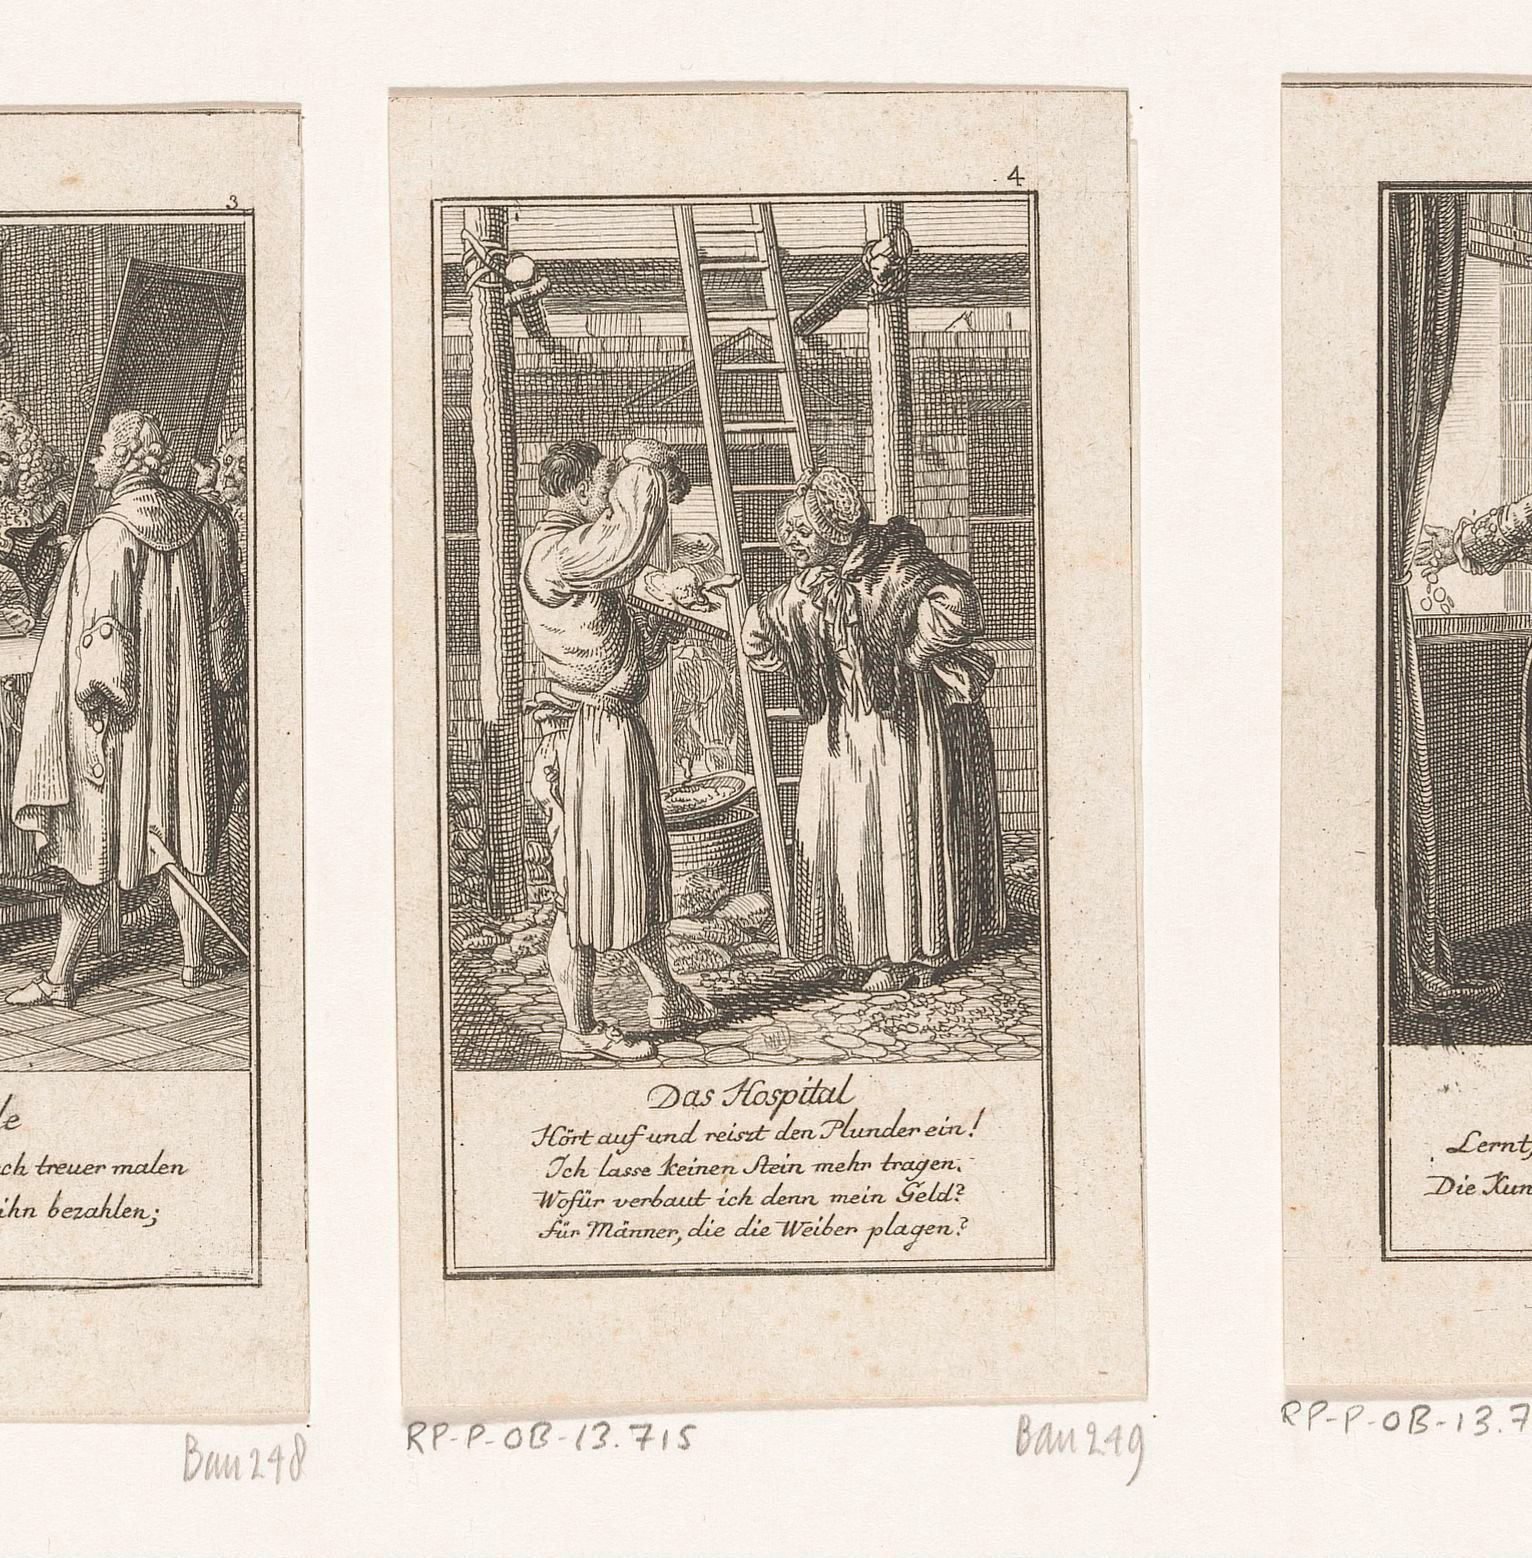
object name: print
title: Elmire en de metselaar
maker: daniel nikolaus chodowiecki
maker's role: draughtsman, print maker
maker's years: 1726-1801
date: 1775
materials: paper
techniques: etching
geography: berlin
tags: scaffold (~ building activities), literature, mason at work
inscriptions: collector's mark: Lugt 2228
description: Elmire had gezworen om nooit meer te trouwen. Wanneer ze toch met een man in het huwelijk treedt neemt ze zich voor om, indien het huwelijk gelukkig is, een ziekenhuis te stichten. Al snel na het begin van de bouw moet ze het project stop zetten omdat haar man haar heeft verlaten. Dit gebeurt haar driemaal achter elkaar, waarna ze het opgeeft. Op deze scène is Elmire in gesprek met een metselaar voor het ziekenhuis in aanbouw. Rechtsboven genummerd: 4.